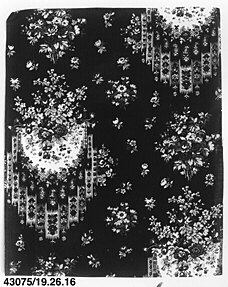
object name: sample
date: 1840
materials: cotton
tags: flowers